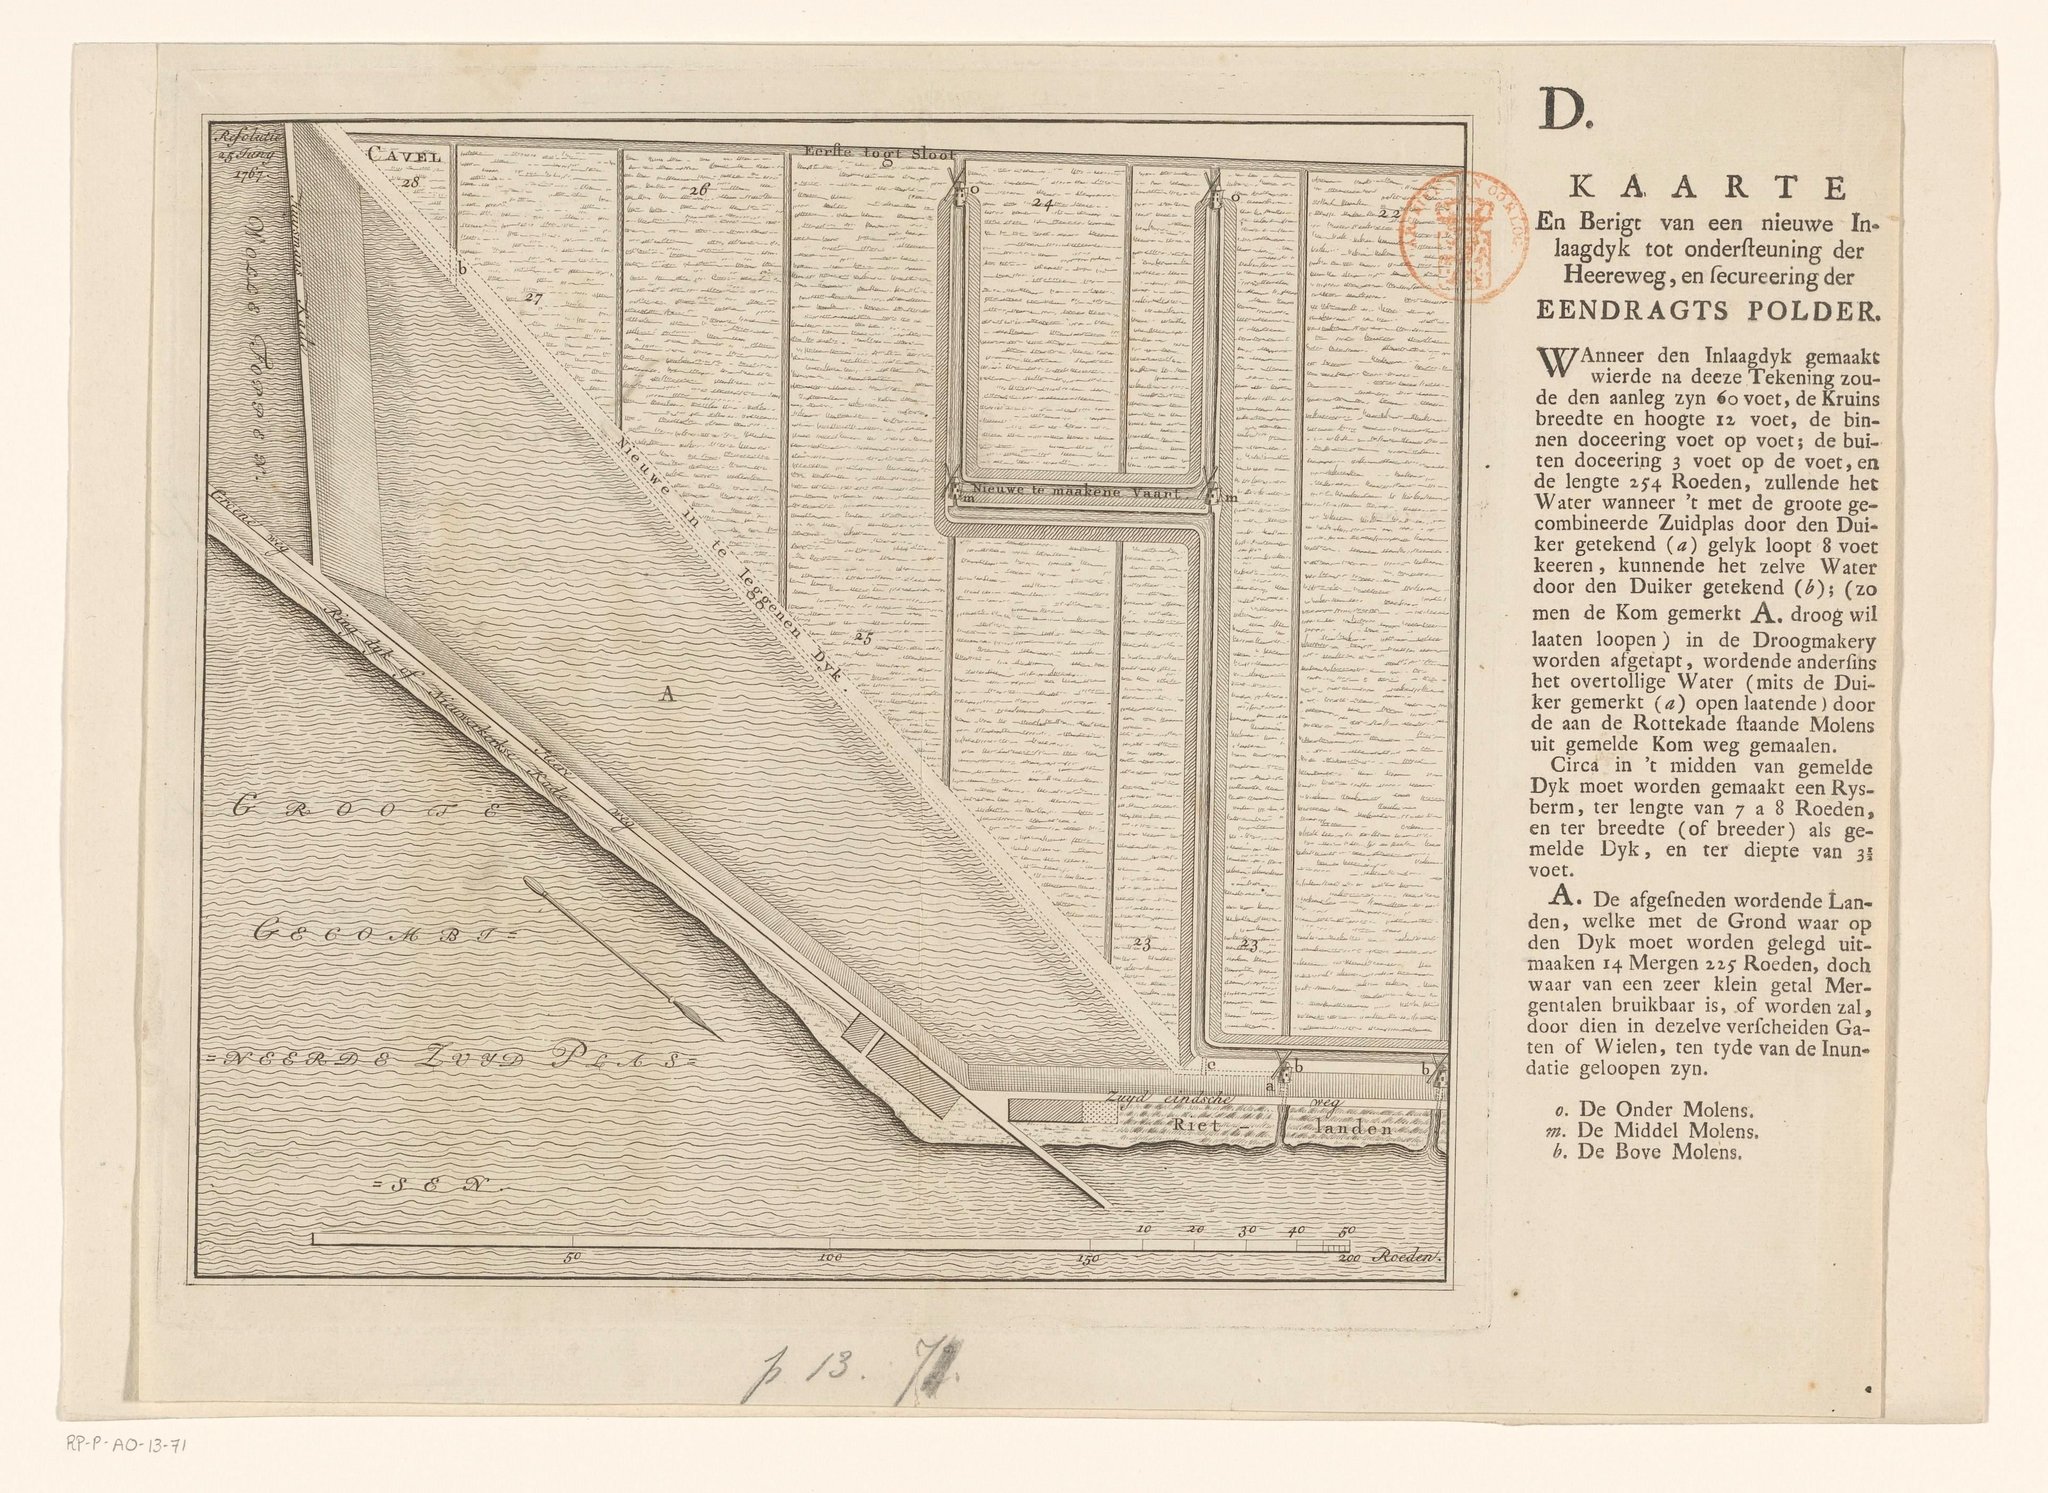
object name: print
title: Kaarte en berigt van een nieuwe inlaagdyk tot ondersteuning der Heereweg, en secureering der Eendragts Polder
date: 1767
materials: paper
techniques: engraving, etching, letterpress printing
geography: amsterdam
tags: maps of separate countries or regions, dikes, levee, polder, reclaimed land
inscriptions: collector's mark: Lugt 19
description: Kaart van de Eendragtspolder met ontwerp voor een nieuwe inlaagdijk en een nieuwe vaart. Onderaan de kaart een schaalstok: 200 roeden. Rechts van de kaart tekst met uitleg en legenda.